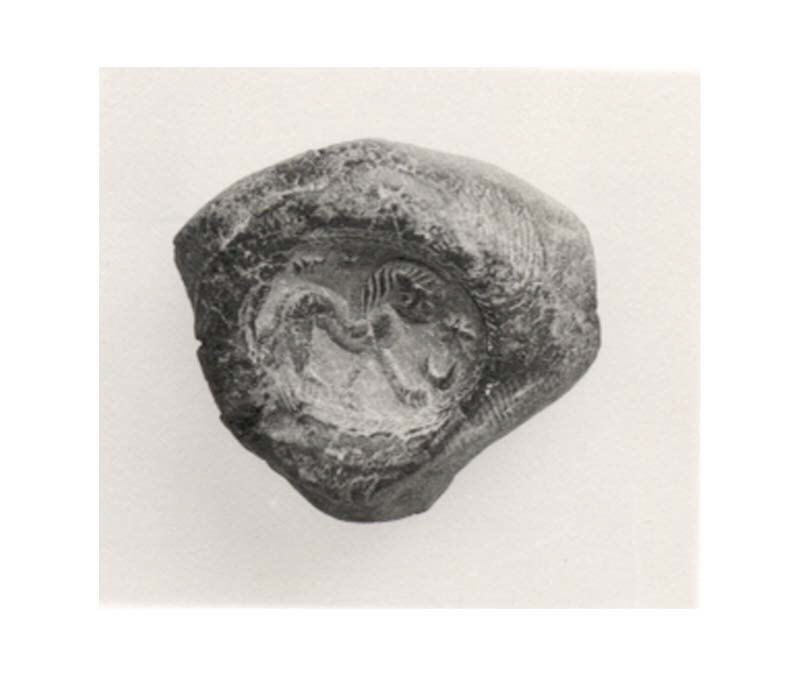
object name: sealing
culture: sasanian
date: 601-700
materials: clay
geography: iran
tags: animals